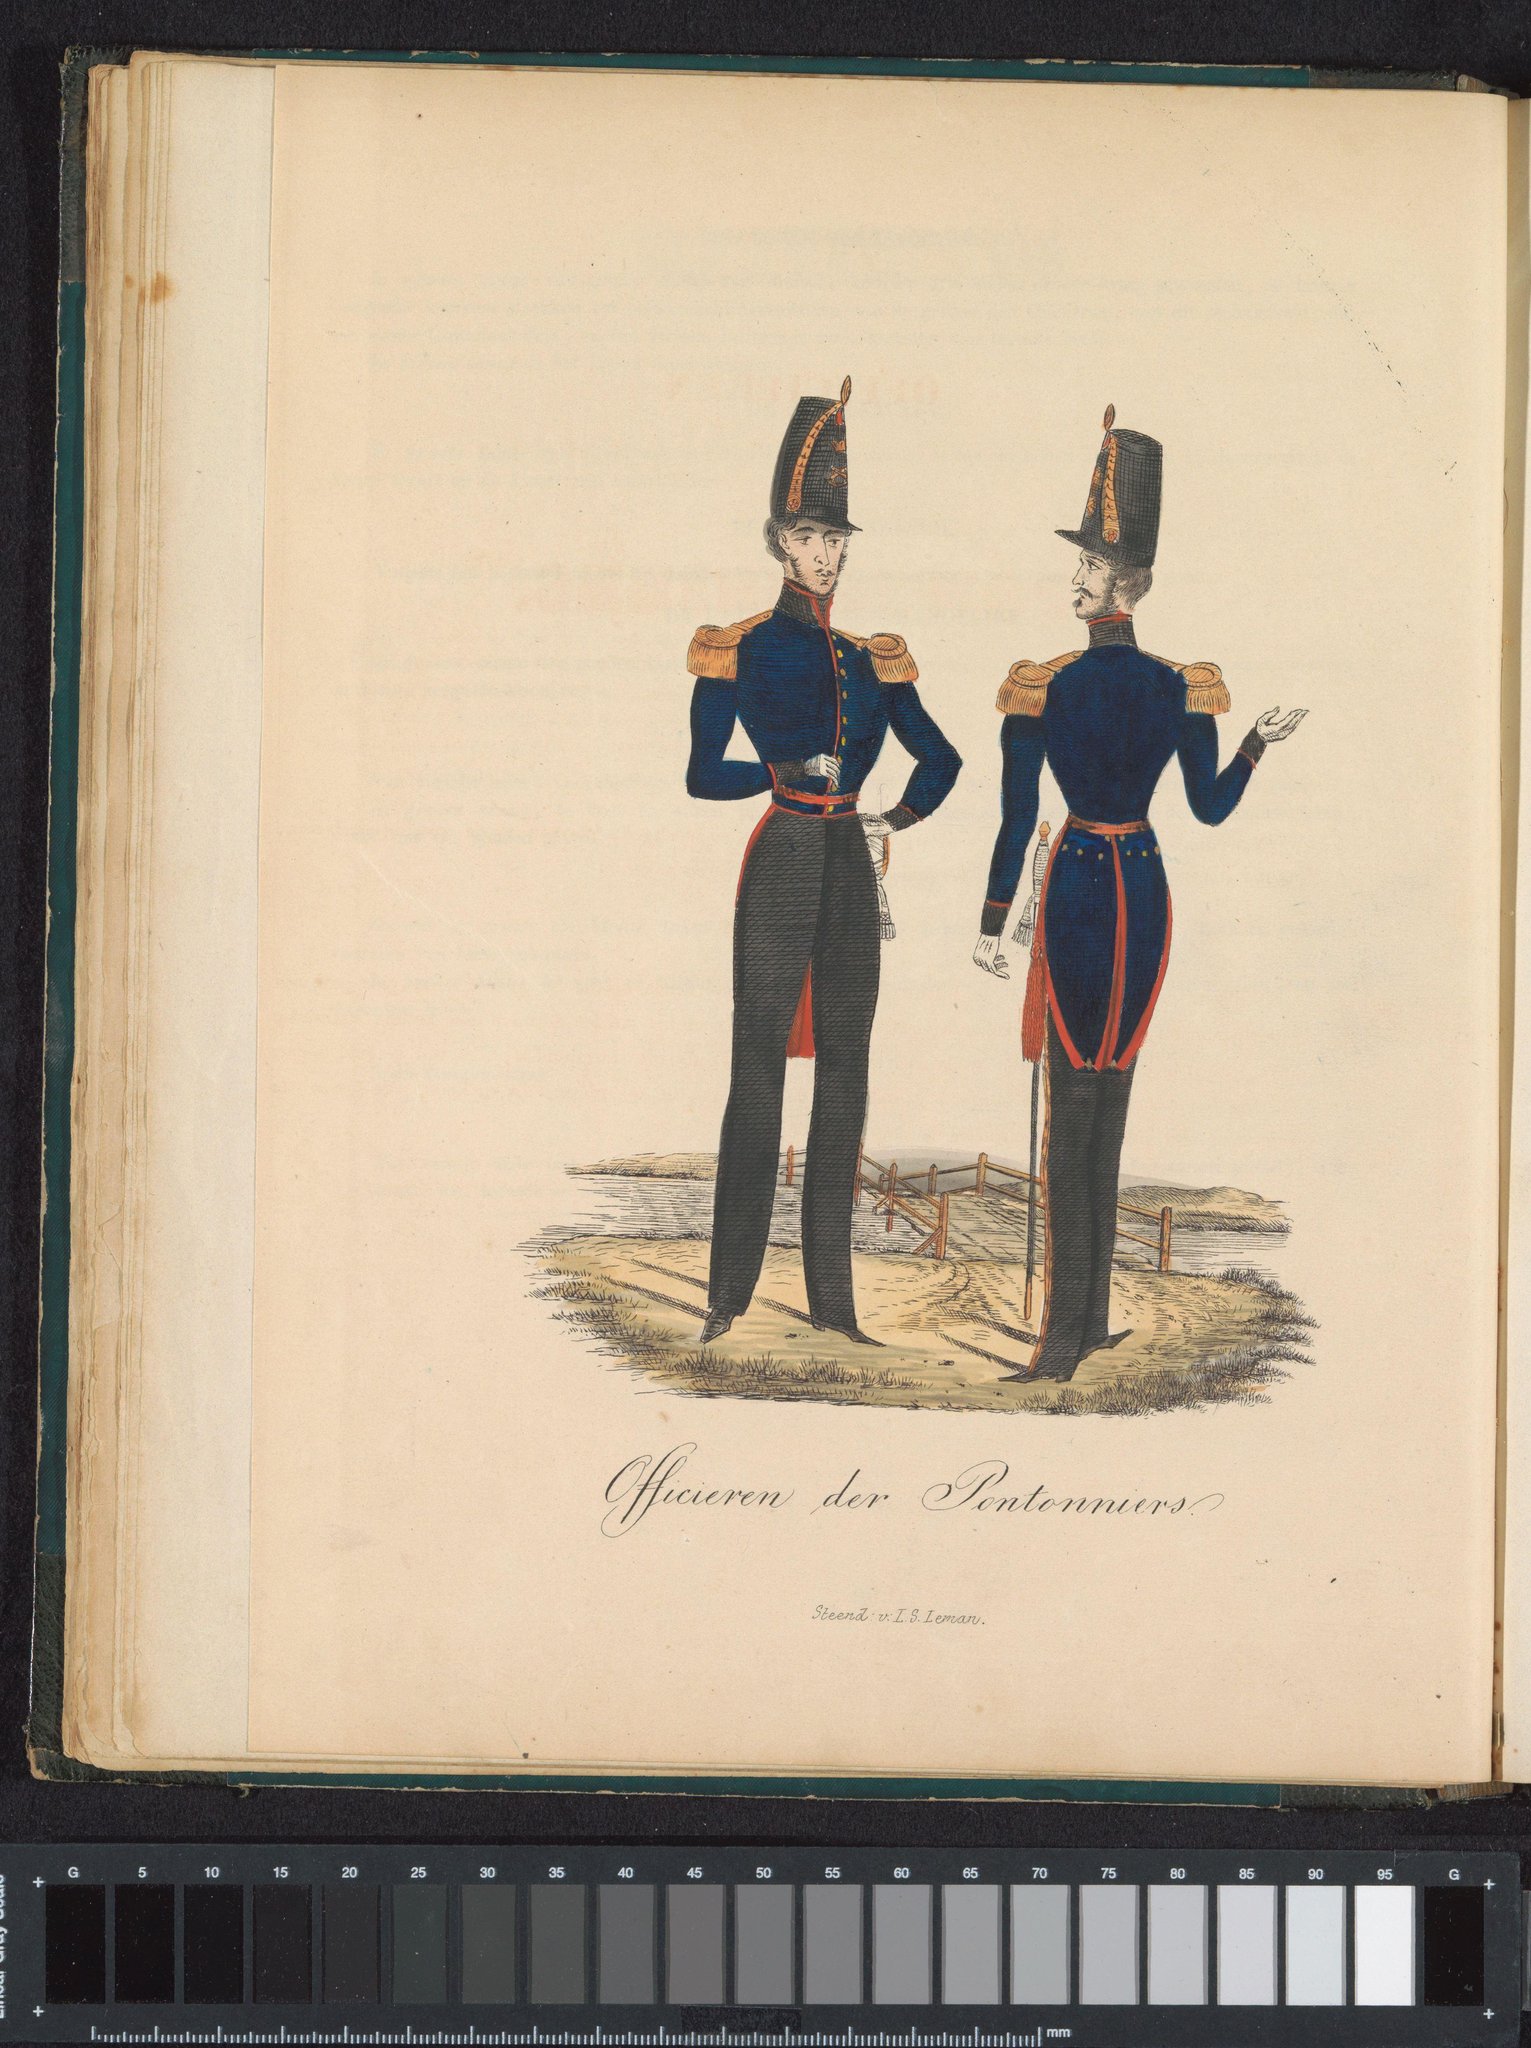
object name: book illustration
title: Officieren der Pontonniers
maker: louis salomon leman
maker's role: steendrukker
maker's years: 1818-1889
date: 1845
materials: paper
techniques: hand coloring, lithograph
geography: amsterdam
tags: (military) uniforms, netherlands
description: Uniform van de officieren van de pontonniers. Illustratie in een boek uit 1845 over de uniformen en kledingstukken van de Nederlandse land-, zeemacht en schutterijen in Nederland en in de overzeese gebiedsdelen.